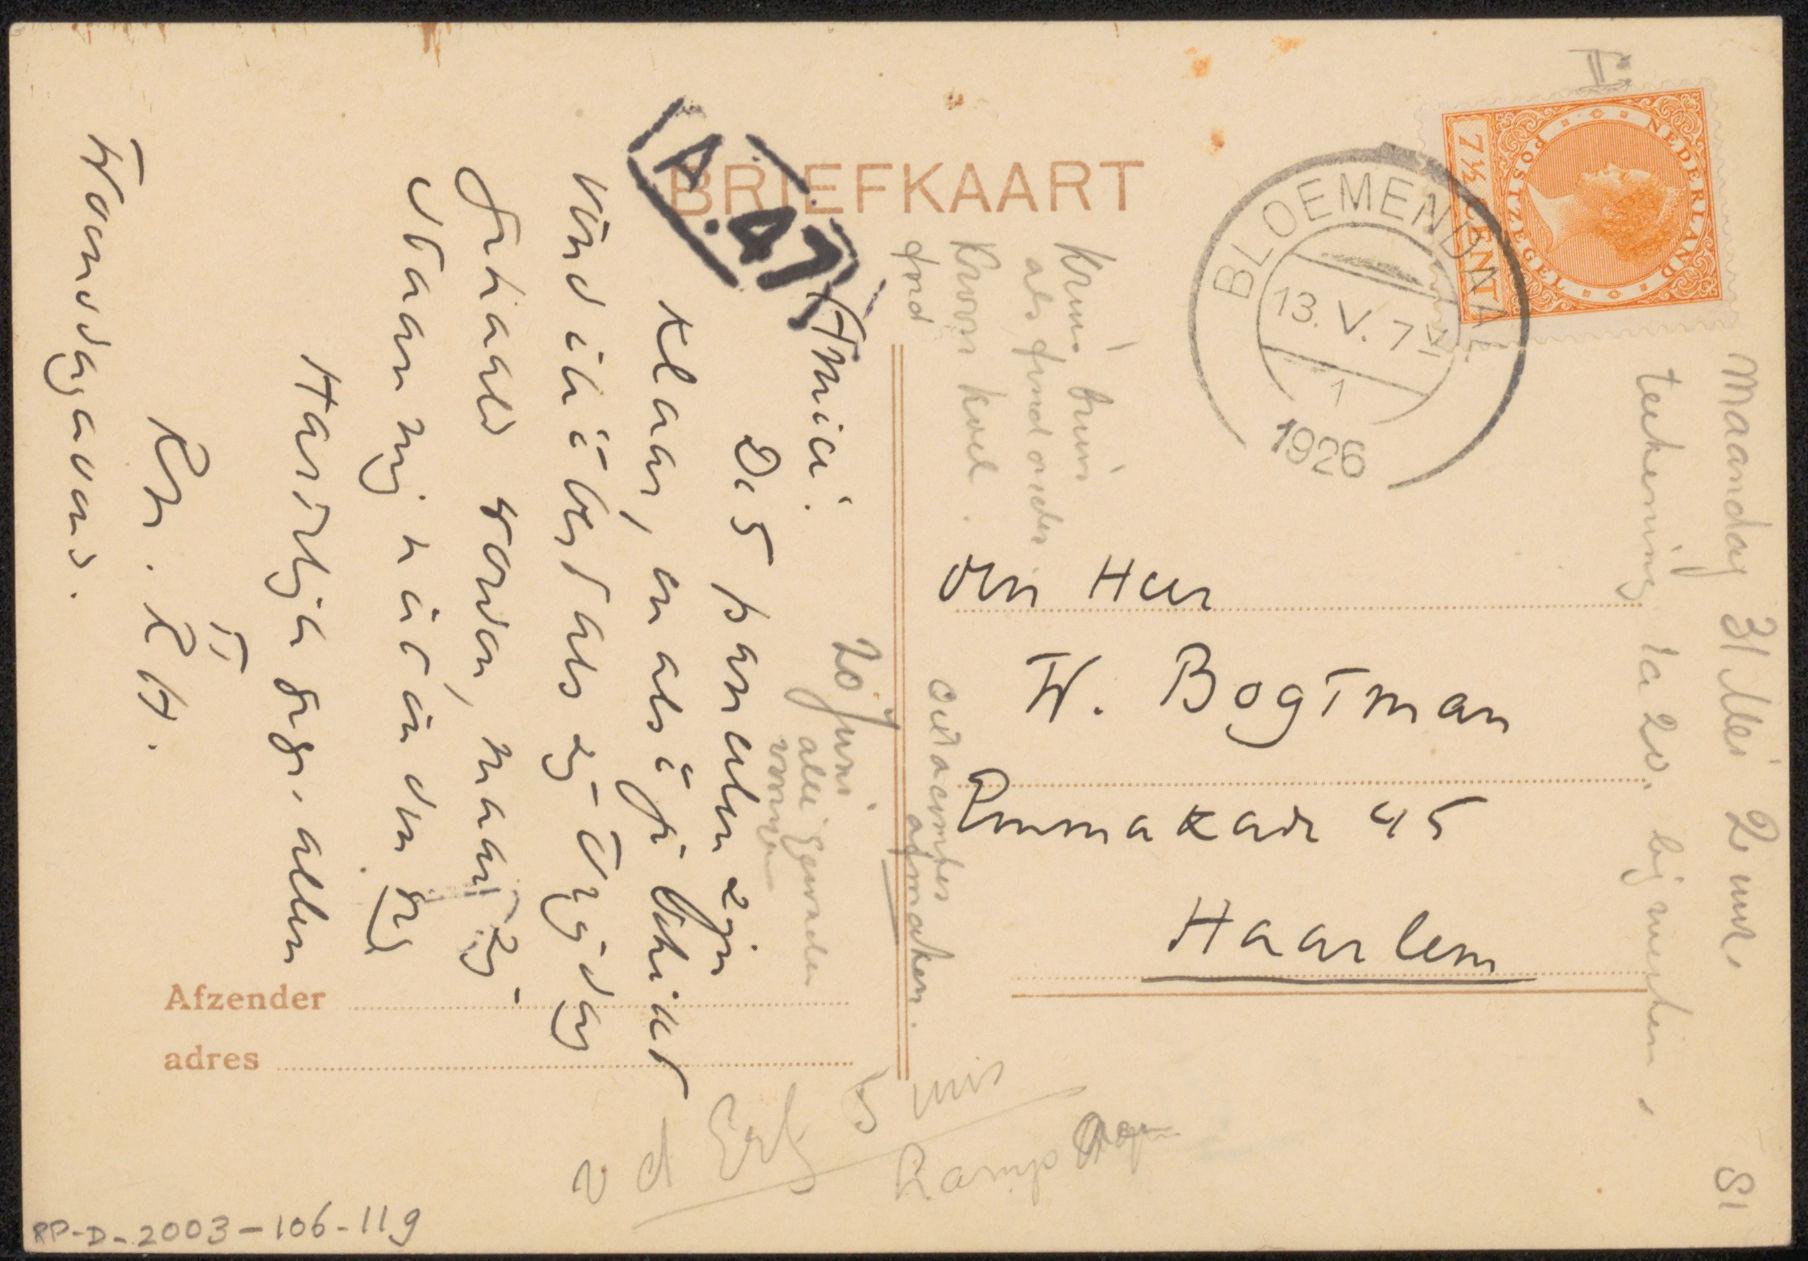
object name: postcard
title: Briefkaart aan Willem Bogtman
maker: richard nicolaüs roland holst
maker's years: 1868-1938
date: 1926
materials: cardboard, ink, pencil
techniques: pen, writing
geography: bloemendaal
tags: haarlem, willem bogtman, applied arts, arts and crafts; industrial design, plan ~ architecture